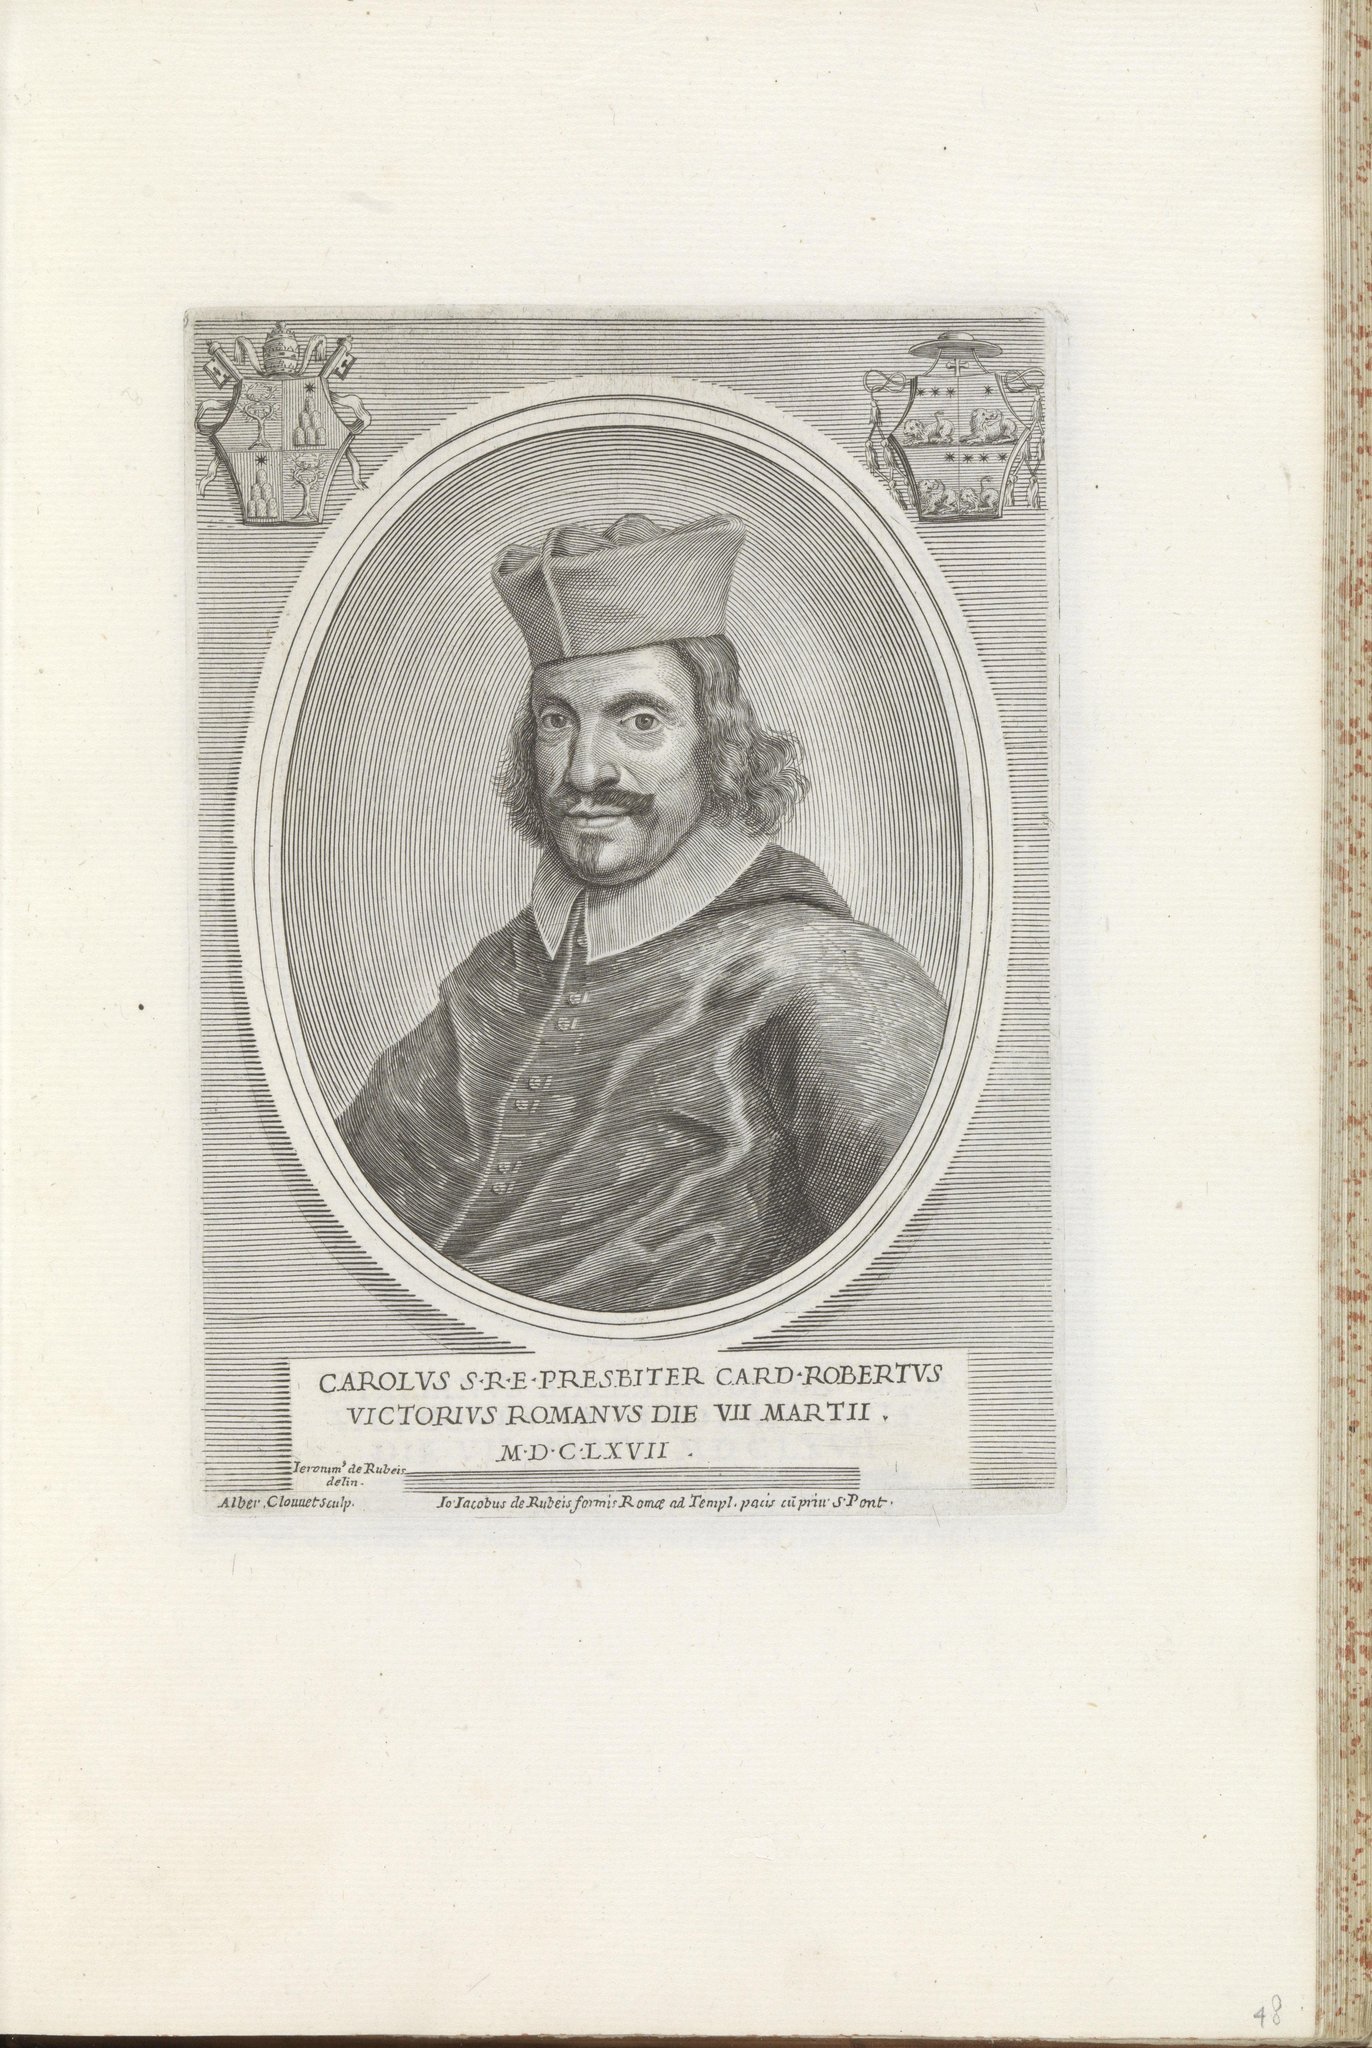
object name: album leaf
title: Portret van kardinaal Carlo Roberti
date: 1667-1679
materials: paper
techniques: engraving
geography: rome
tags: cardinal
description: Portret van kardinaal Carlo Roberti. Linksboven het wapen van paus Alexander VII en rechtsboven het wapen van de kardinaal. Onderaan een onderschrift in het Latijn. De prent maakt deel uit van een album.